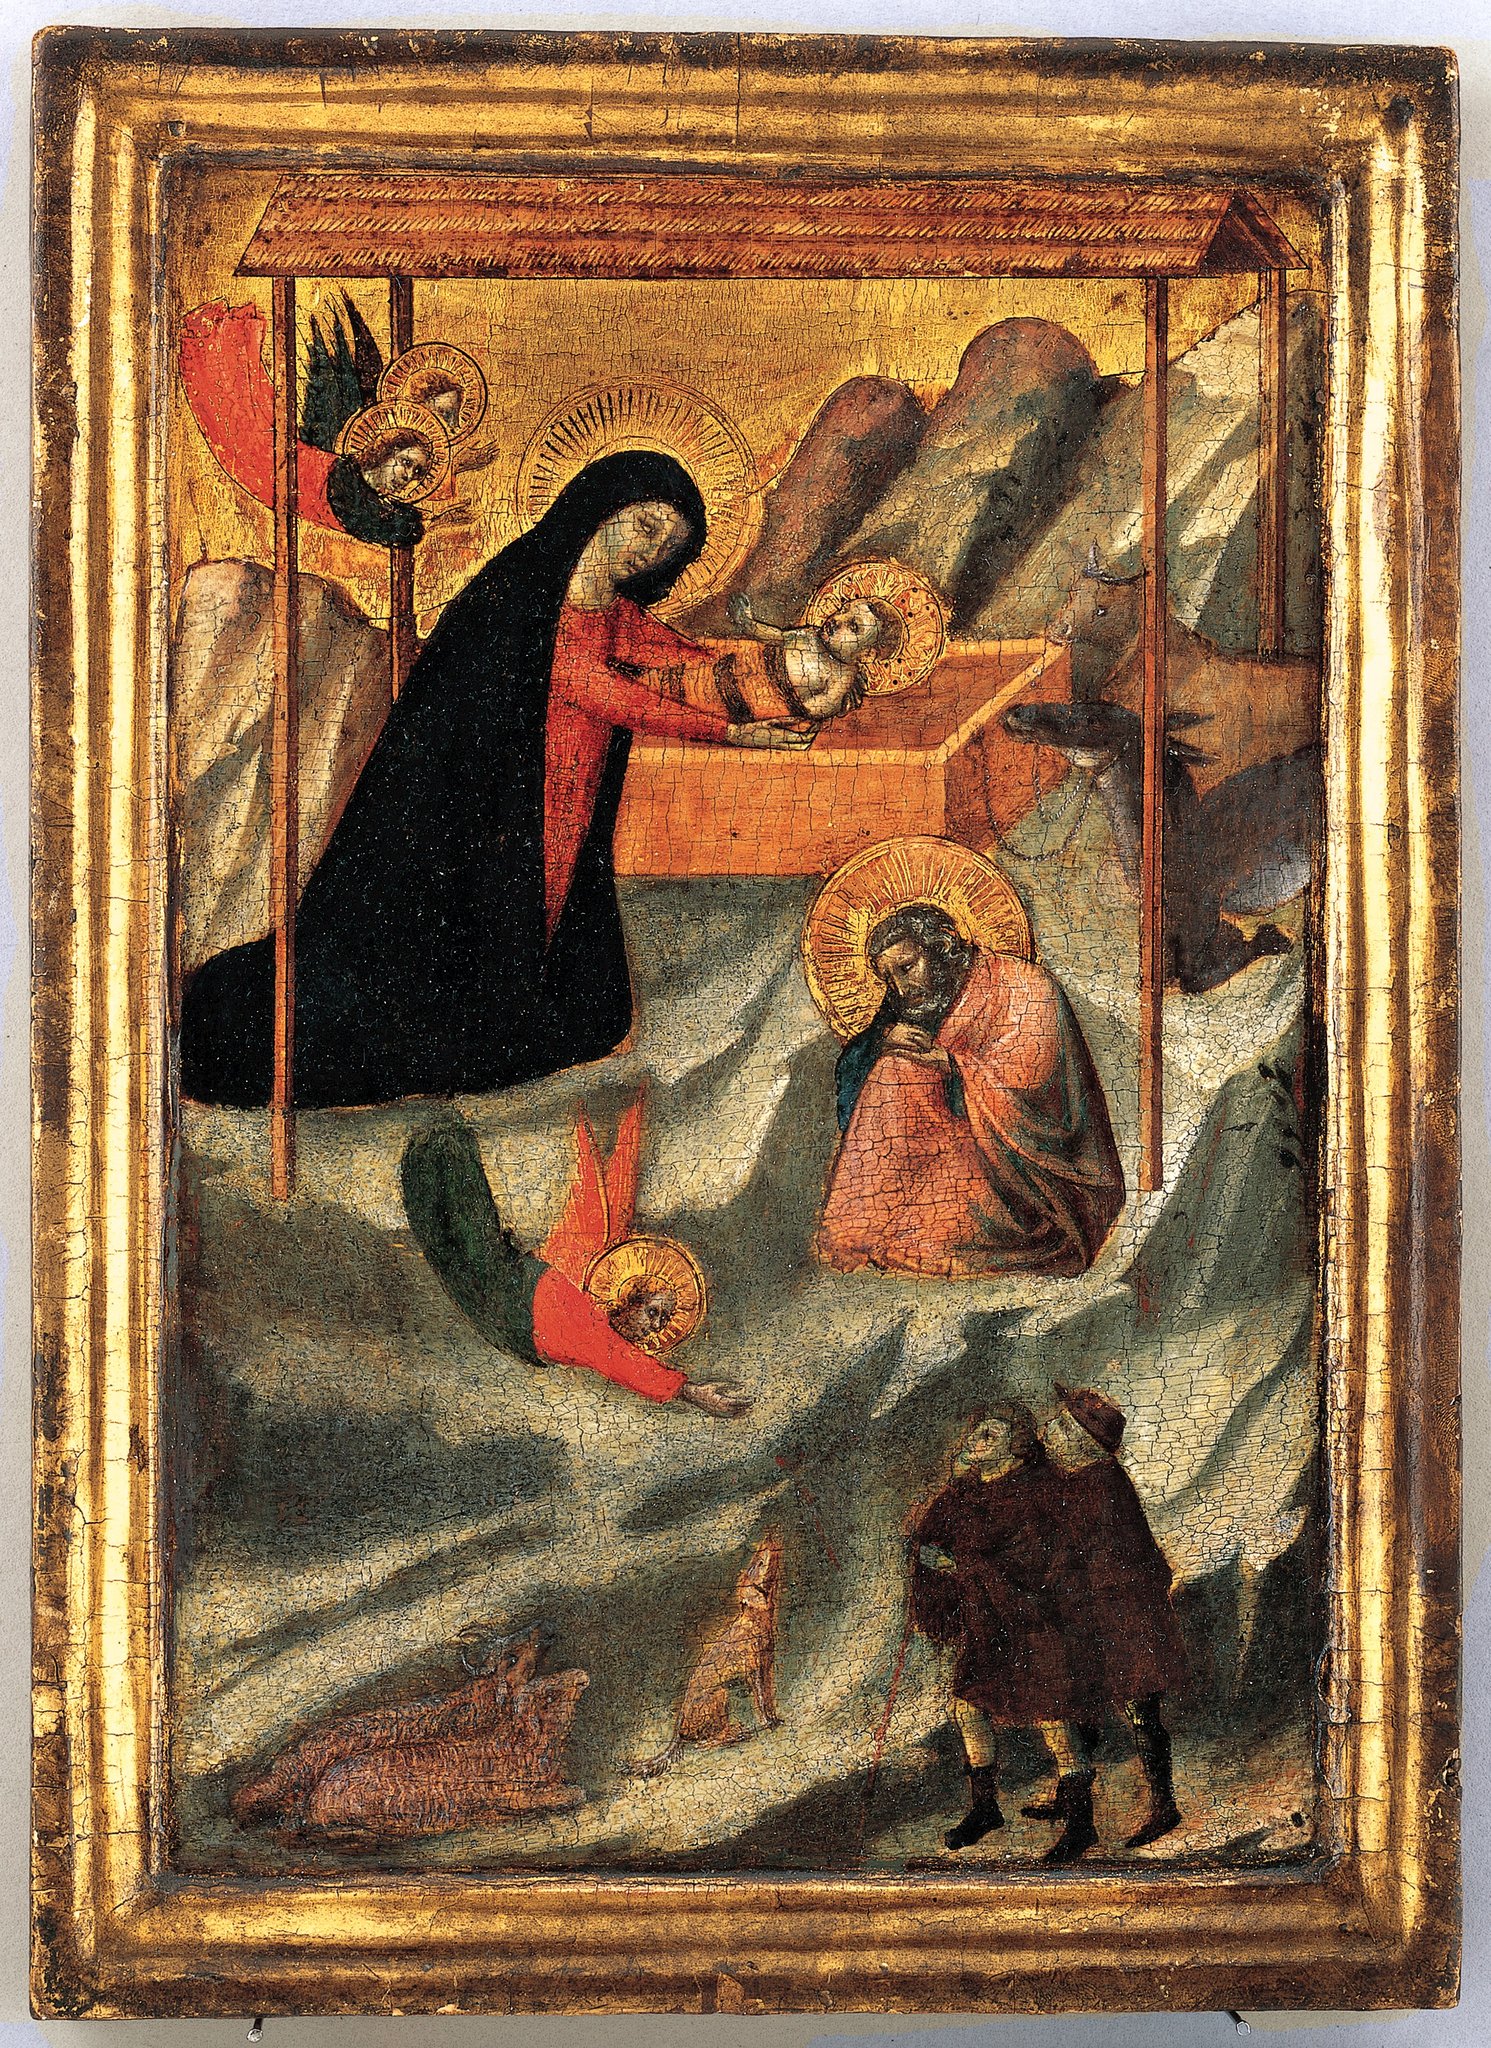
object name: frame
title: Integral frame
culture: italian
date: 1335-1340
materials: linen, wood